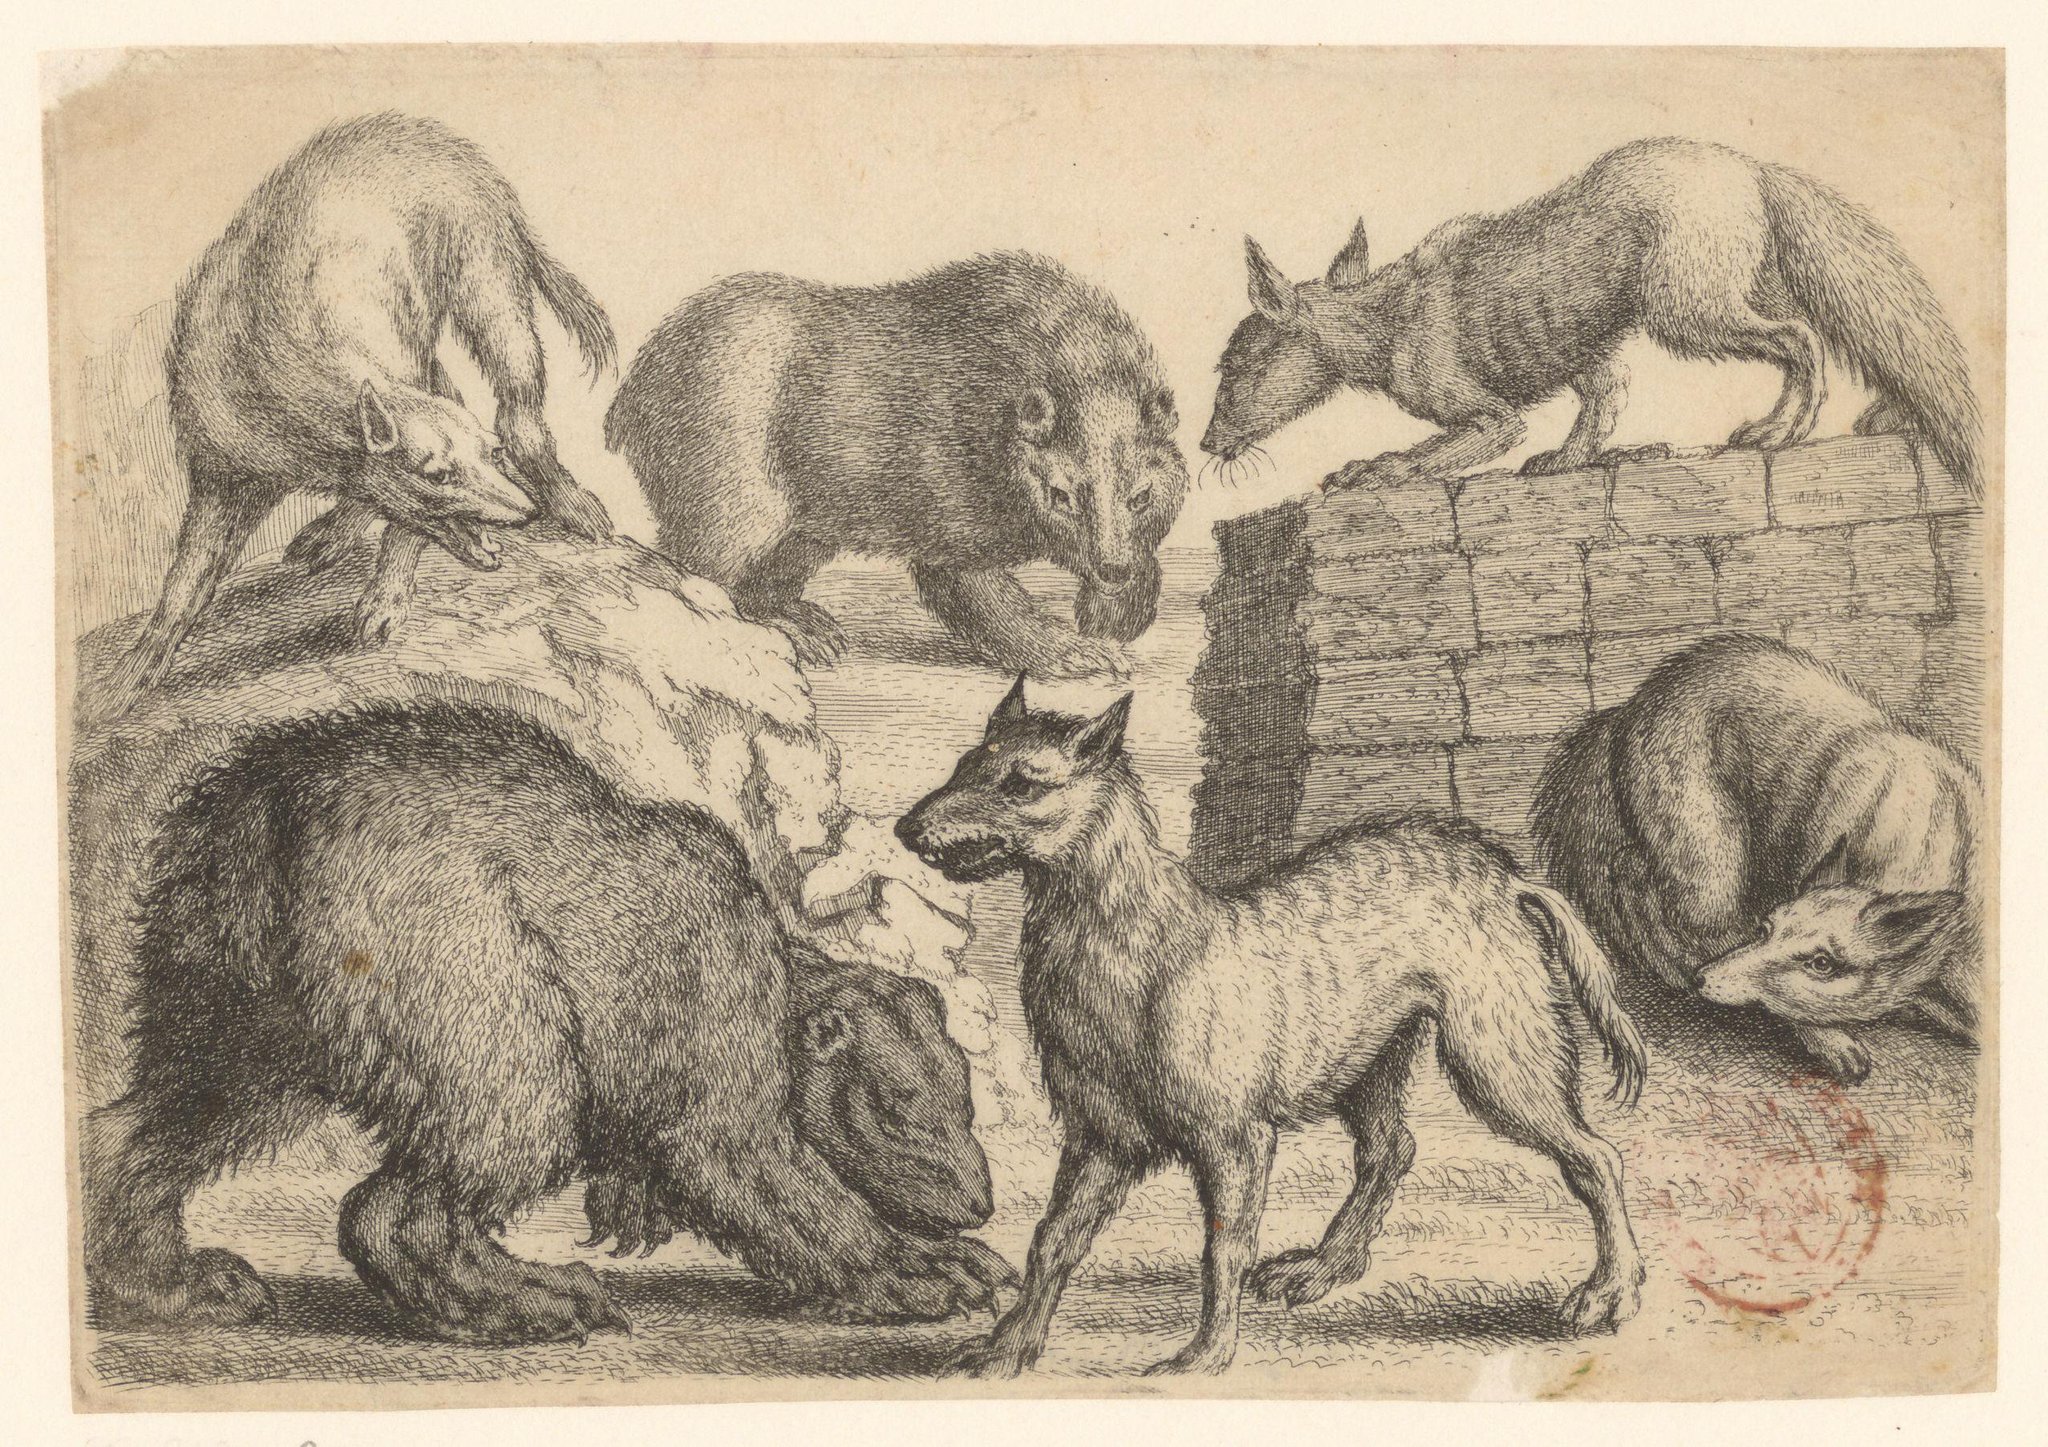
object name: print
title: Dieren naar verschillende kunstenaars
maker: richard gaywood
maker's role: print maker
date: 1654-1670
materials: paper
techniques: etching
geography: london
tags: beasts of prey, predatory animals: bear, beasts of prey, predatory animals: fox, beasts of prey, predatory animals: wolf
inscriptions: collector's mark: Lugt 240